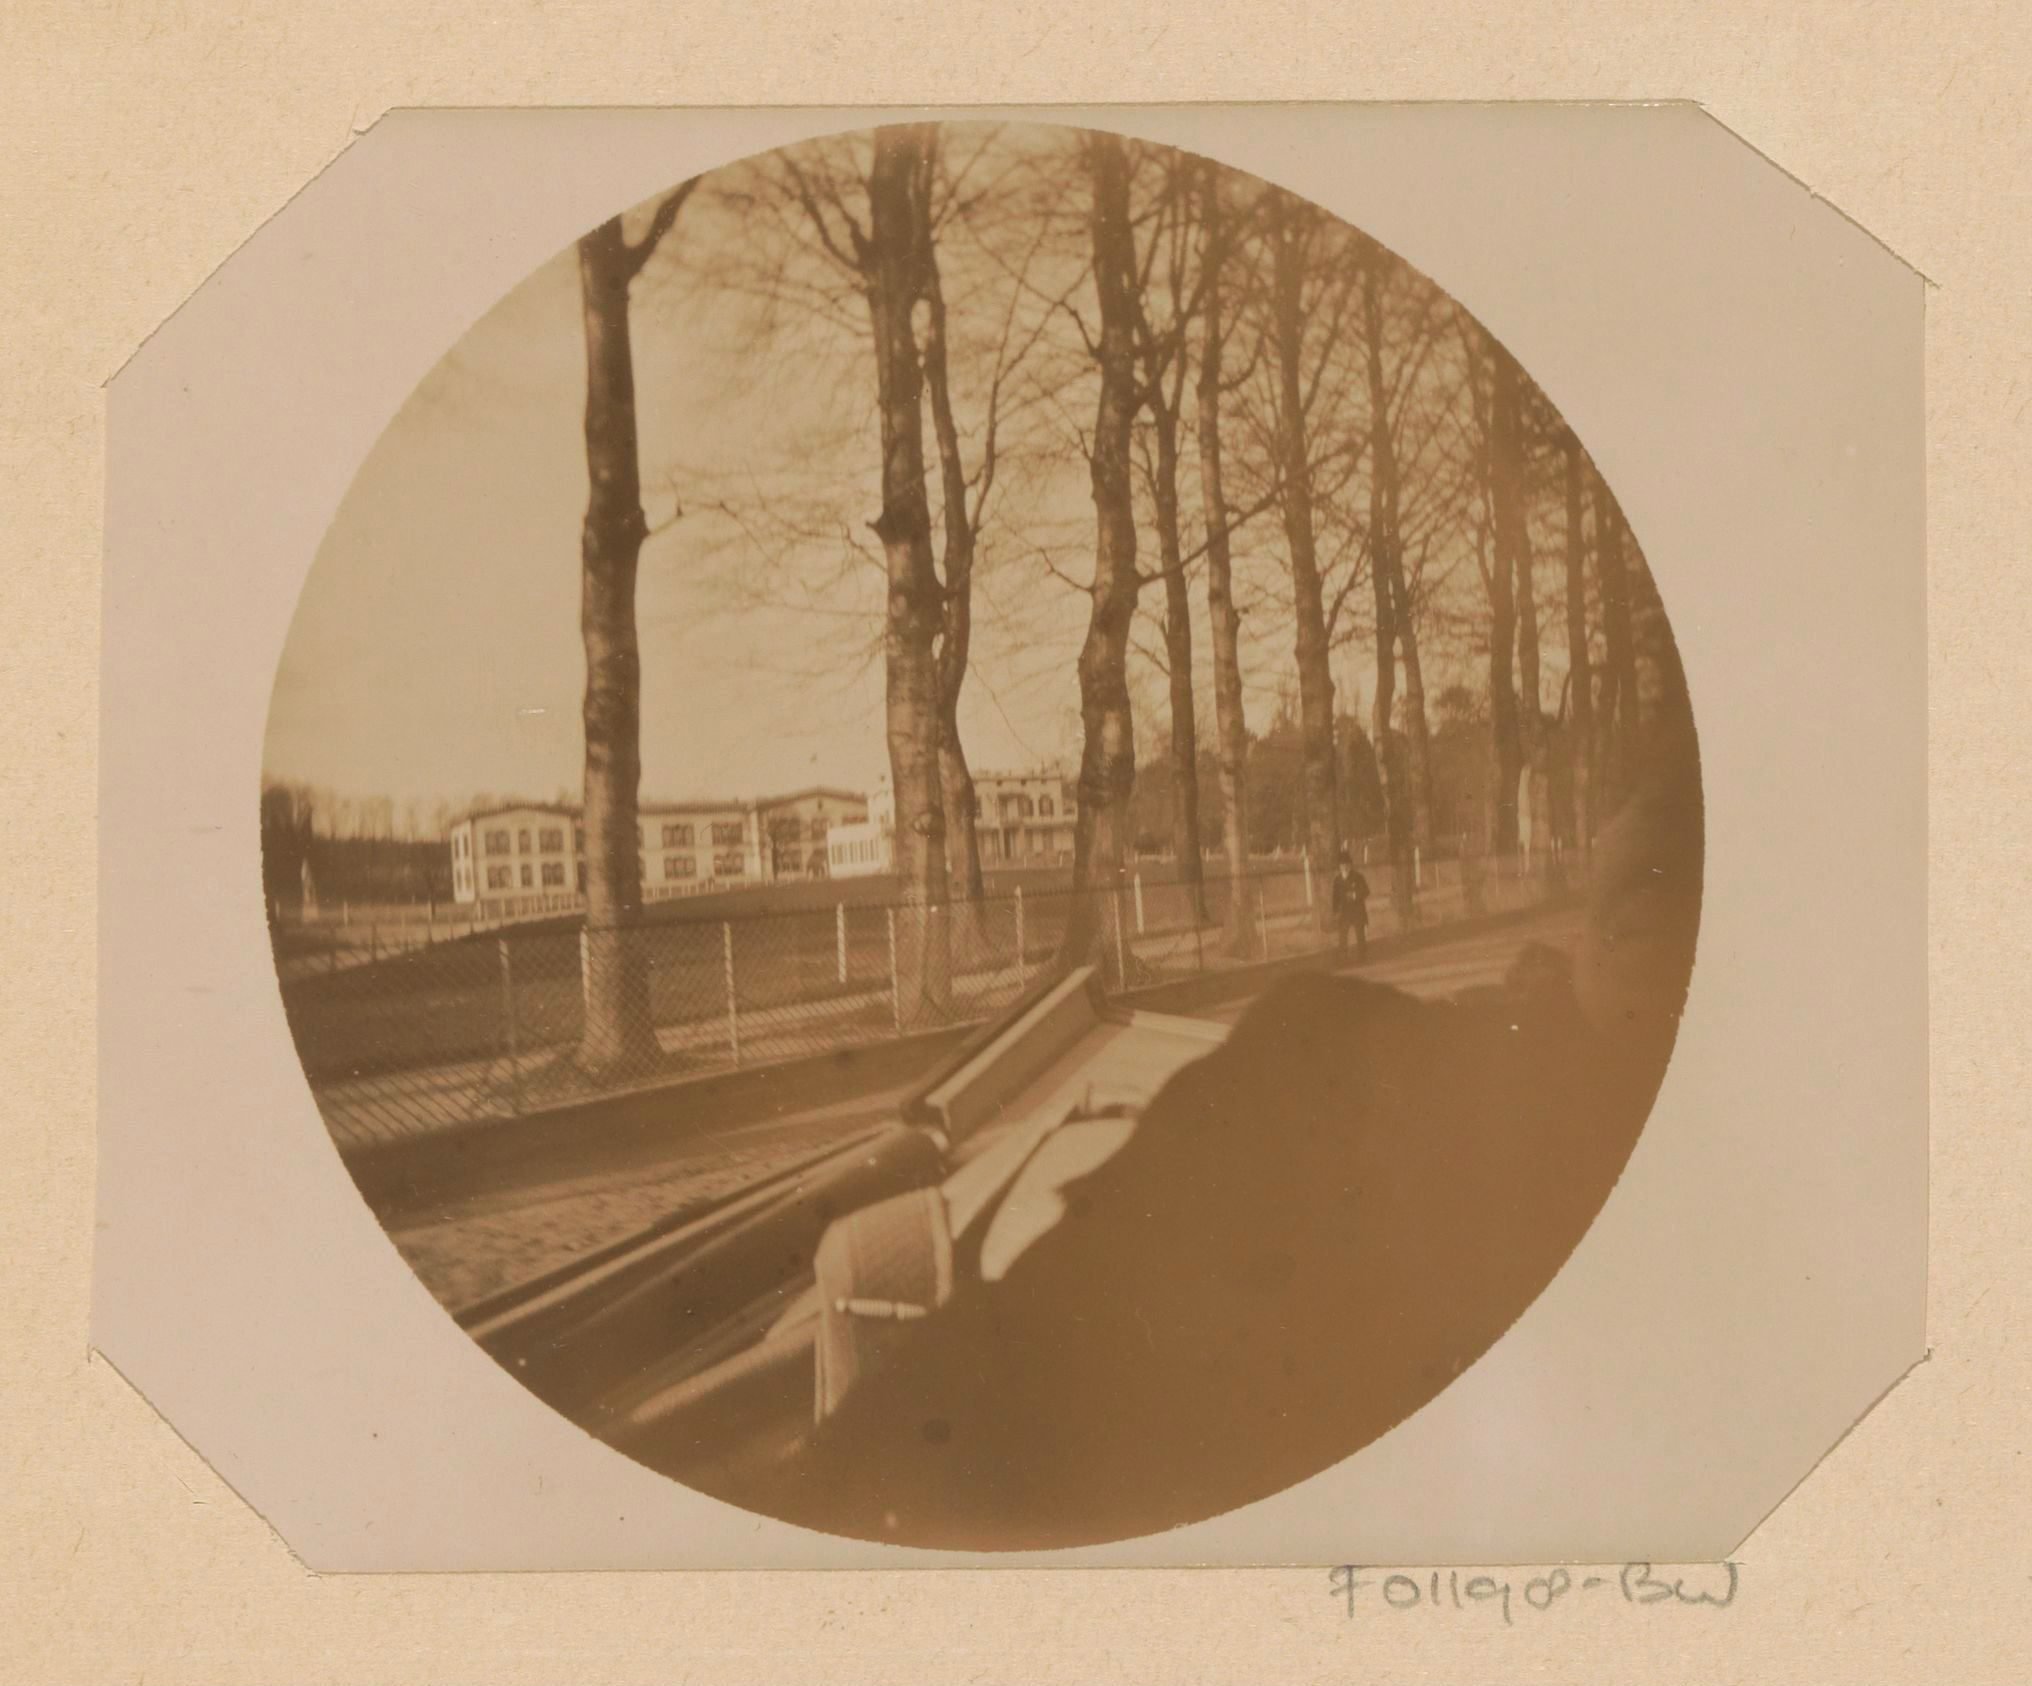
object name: photograph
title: Lucia Wilhelmina Piek-Jolles in een rijtuig, rijdend door een landschap nabij Groot Warnsborn bij Arnhem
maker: johanna margaretha piek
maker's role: fotograaf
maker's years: 1870-1947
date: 1889-1893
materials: paper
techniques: gelatin silver print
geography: arnhem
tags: amsterdam, adult woman